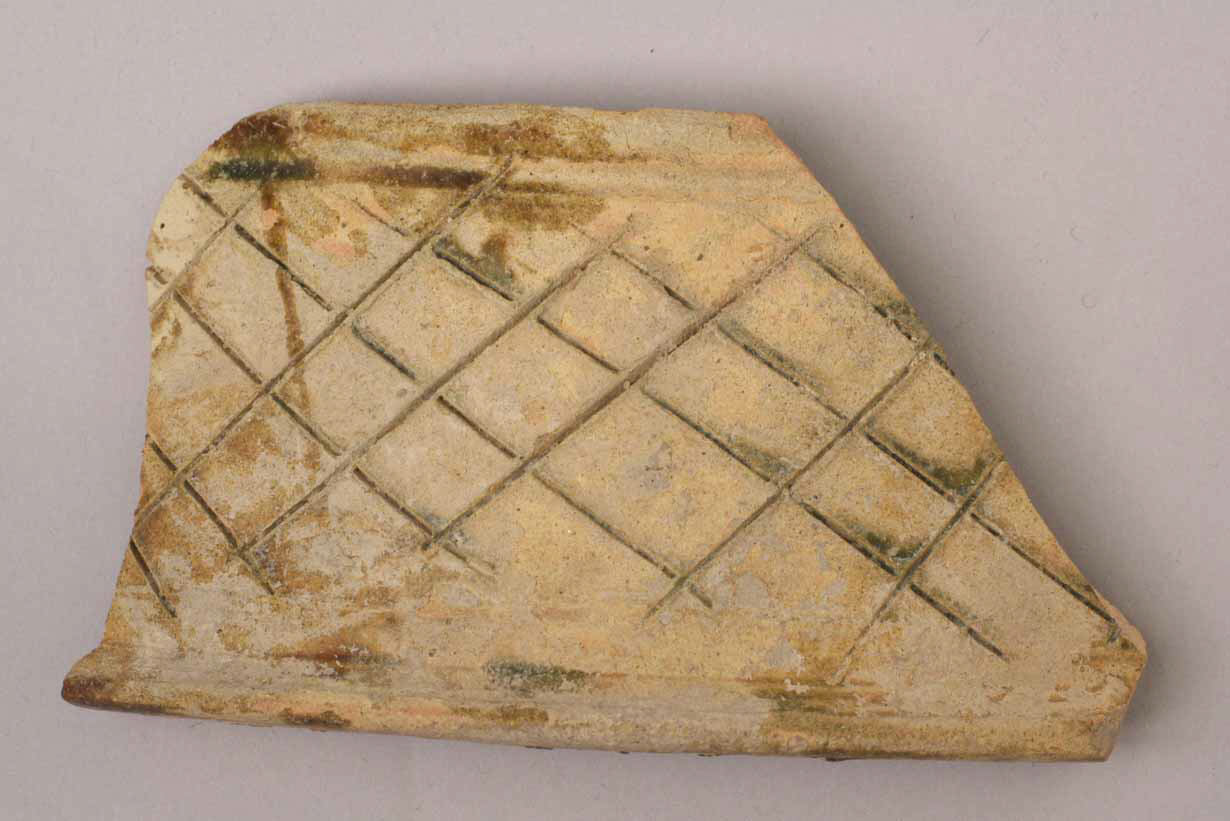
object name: fragment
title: Ceramic Fragment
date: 1001-1100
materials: earthenware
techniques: glazing, incising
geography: saudi arabia